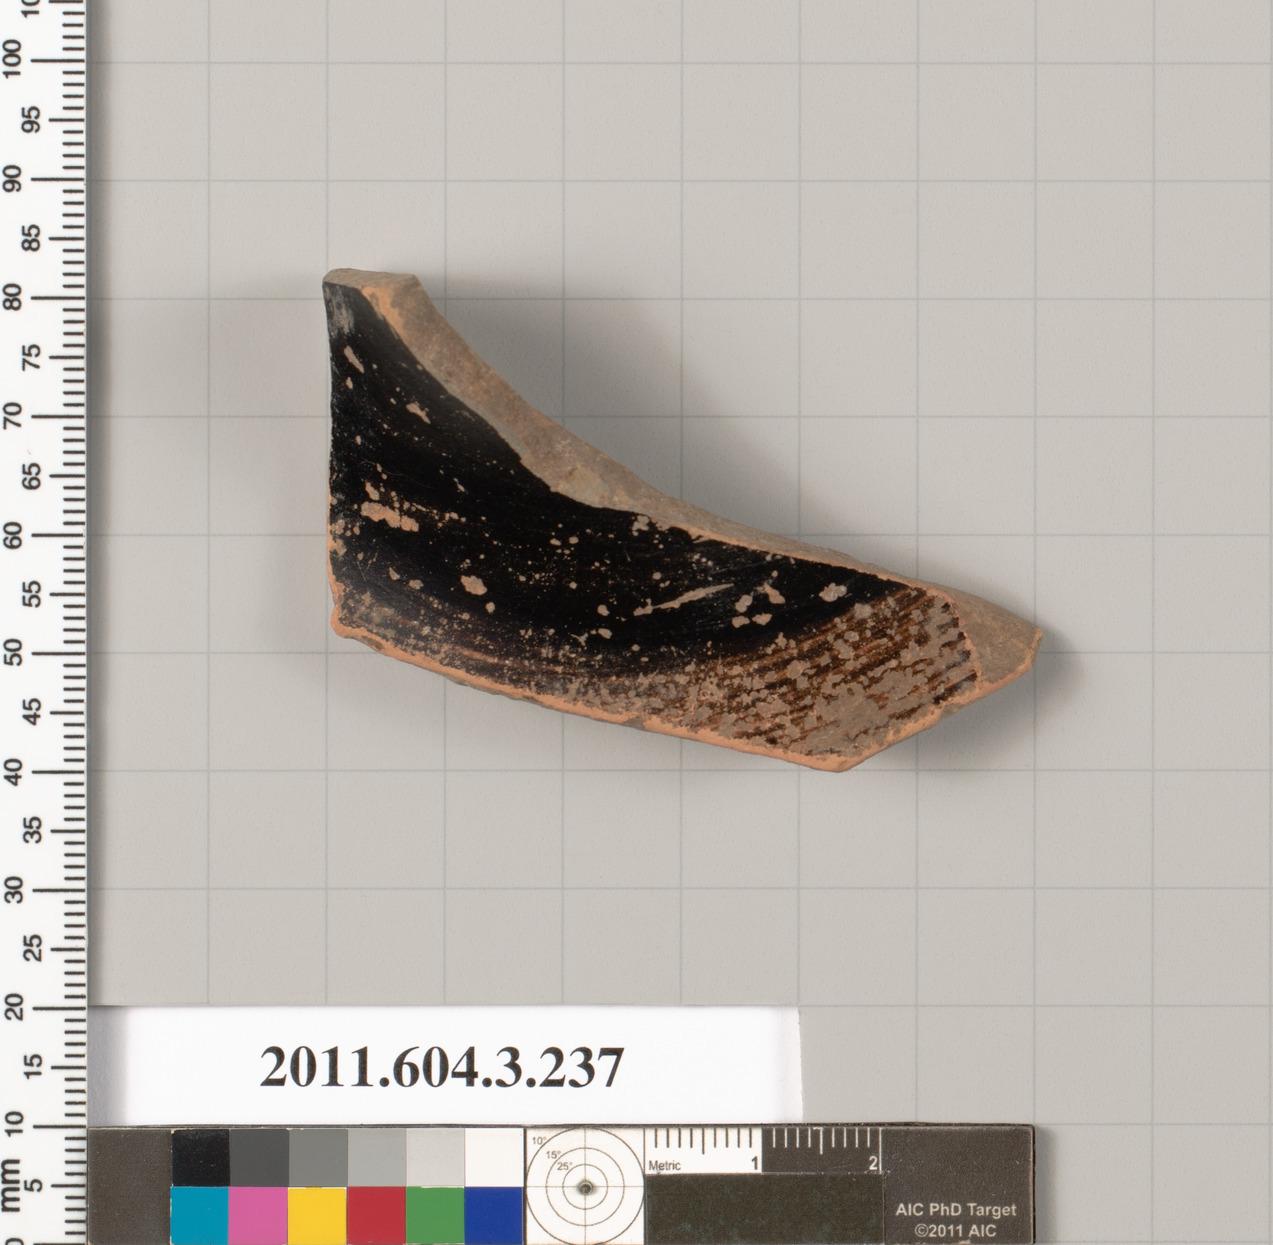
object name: neck amphora fragment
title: Terracotta fragment of a neck-amphora of Nicosthenic shape (jar)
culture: greek, attic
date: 534-468 BCE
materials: terracotta